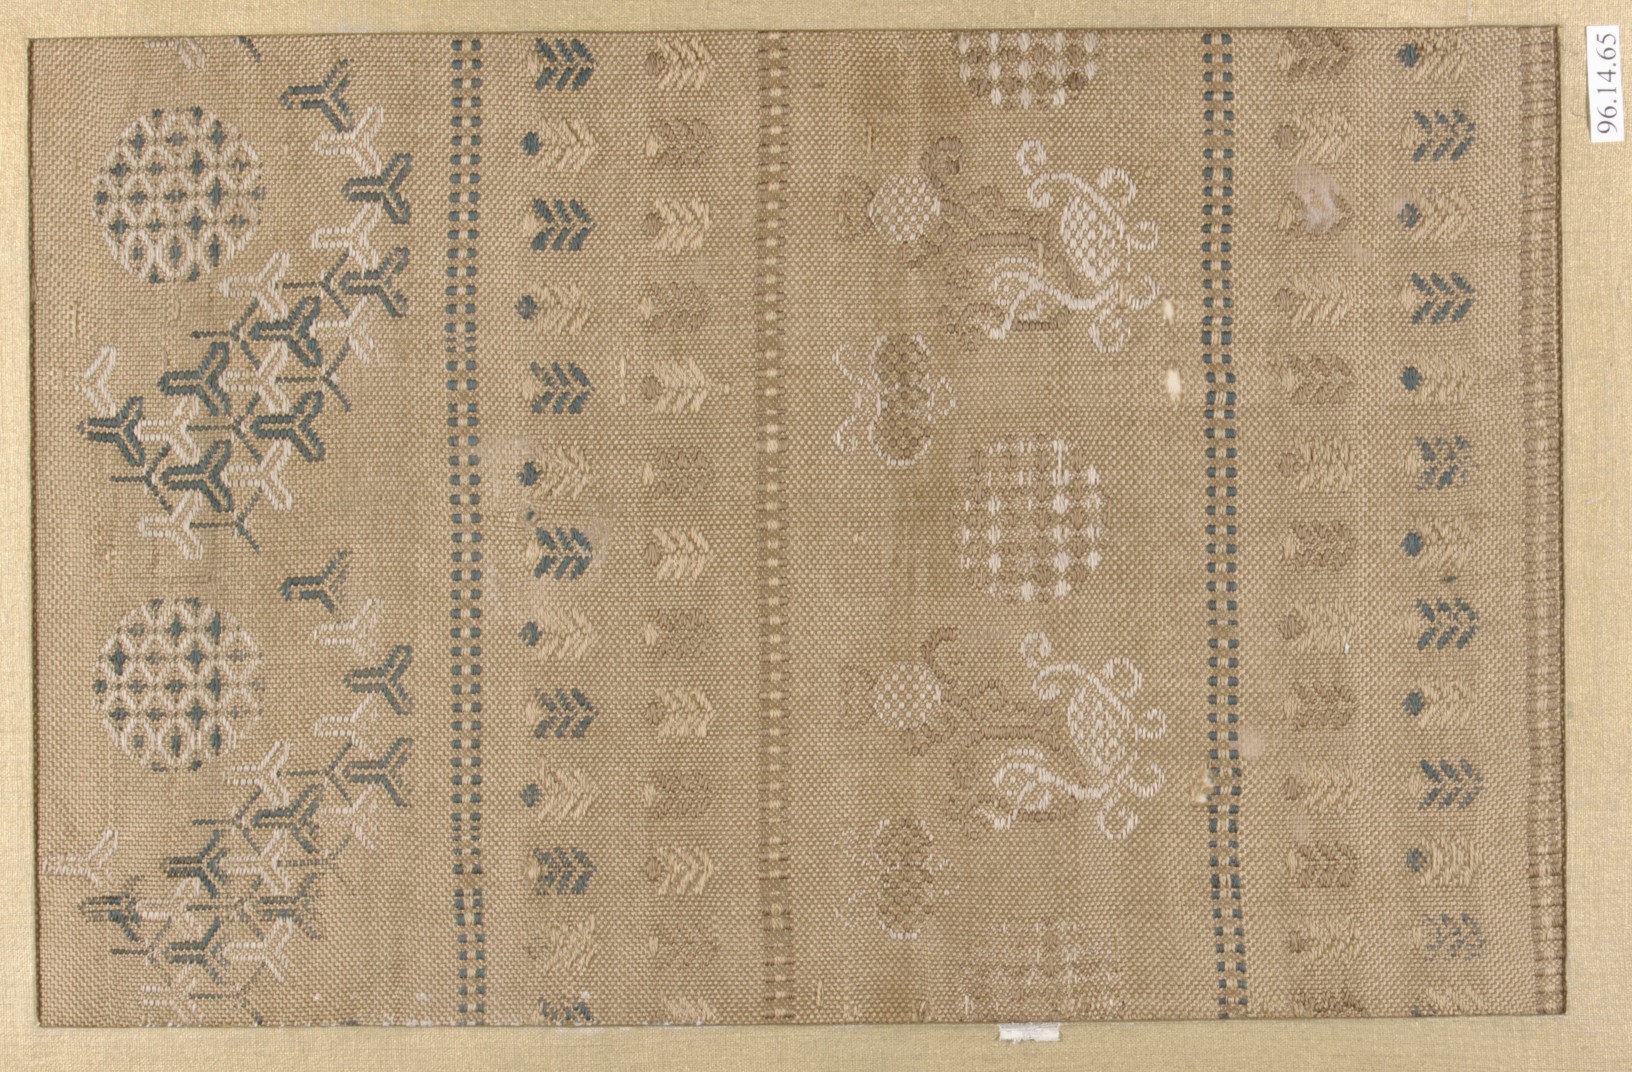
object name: piece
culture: japanese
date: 1701-1800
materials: silk